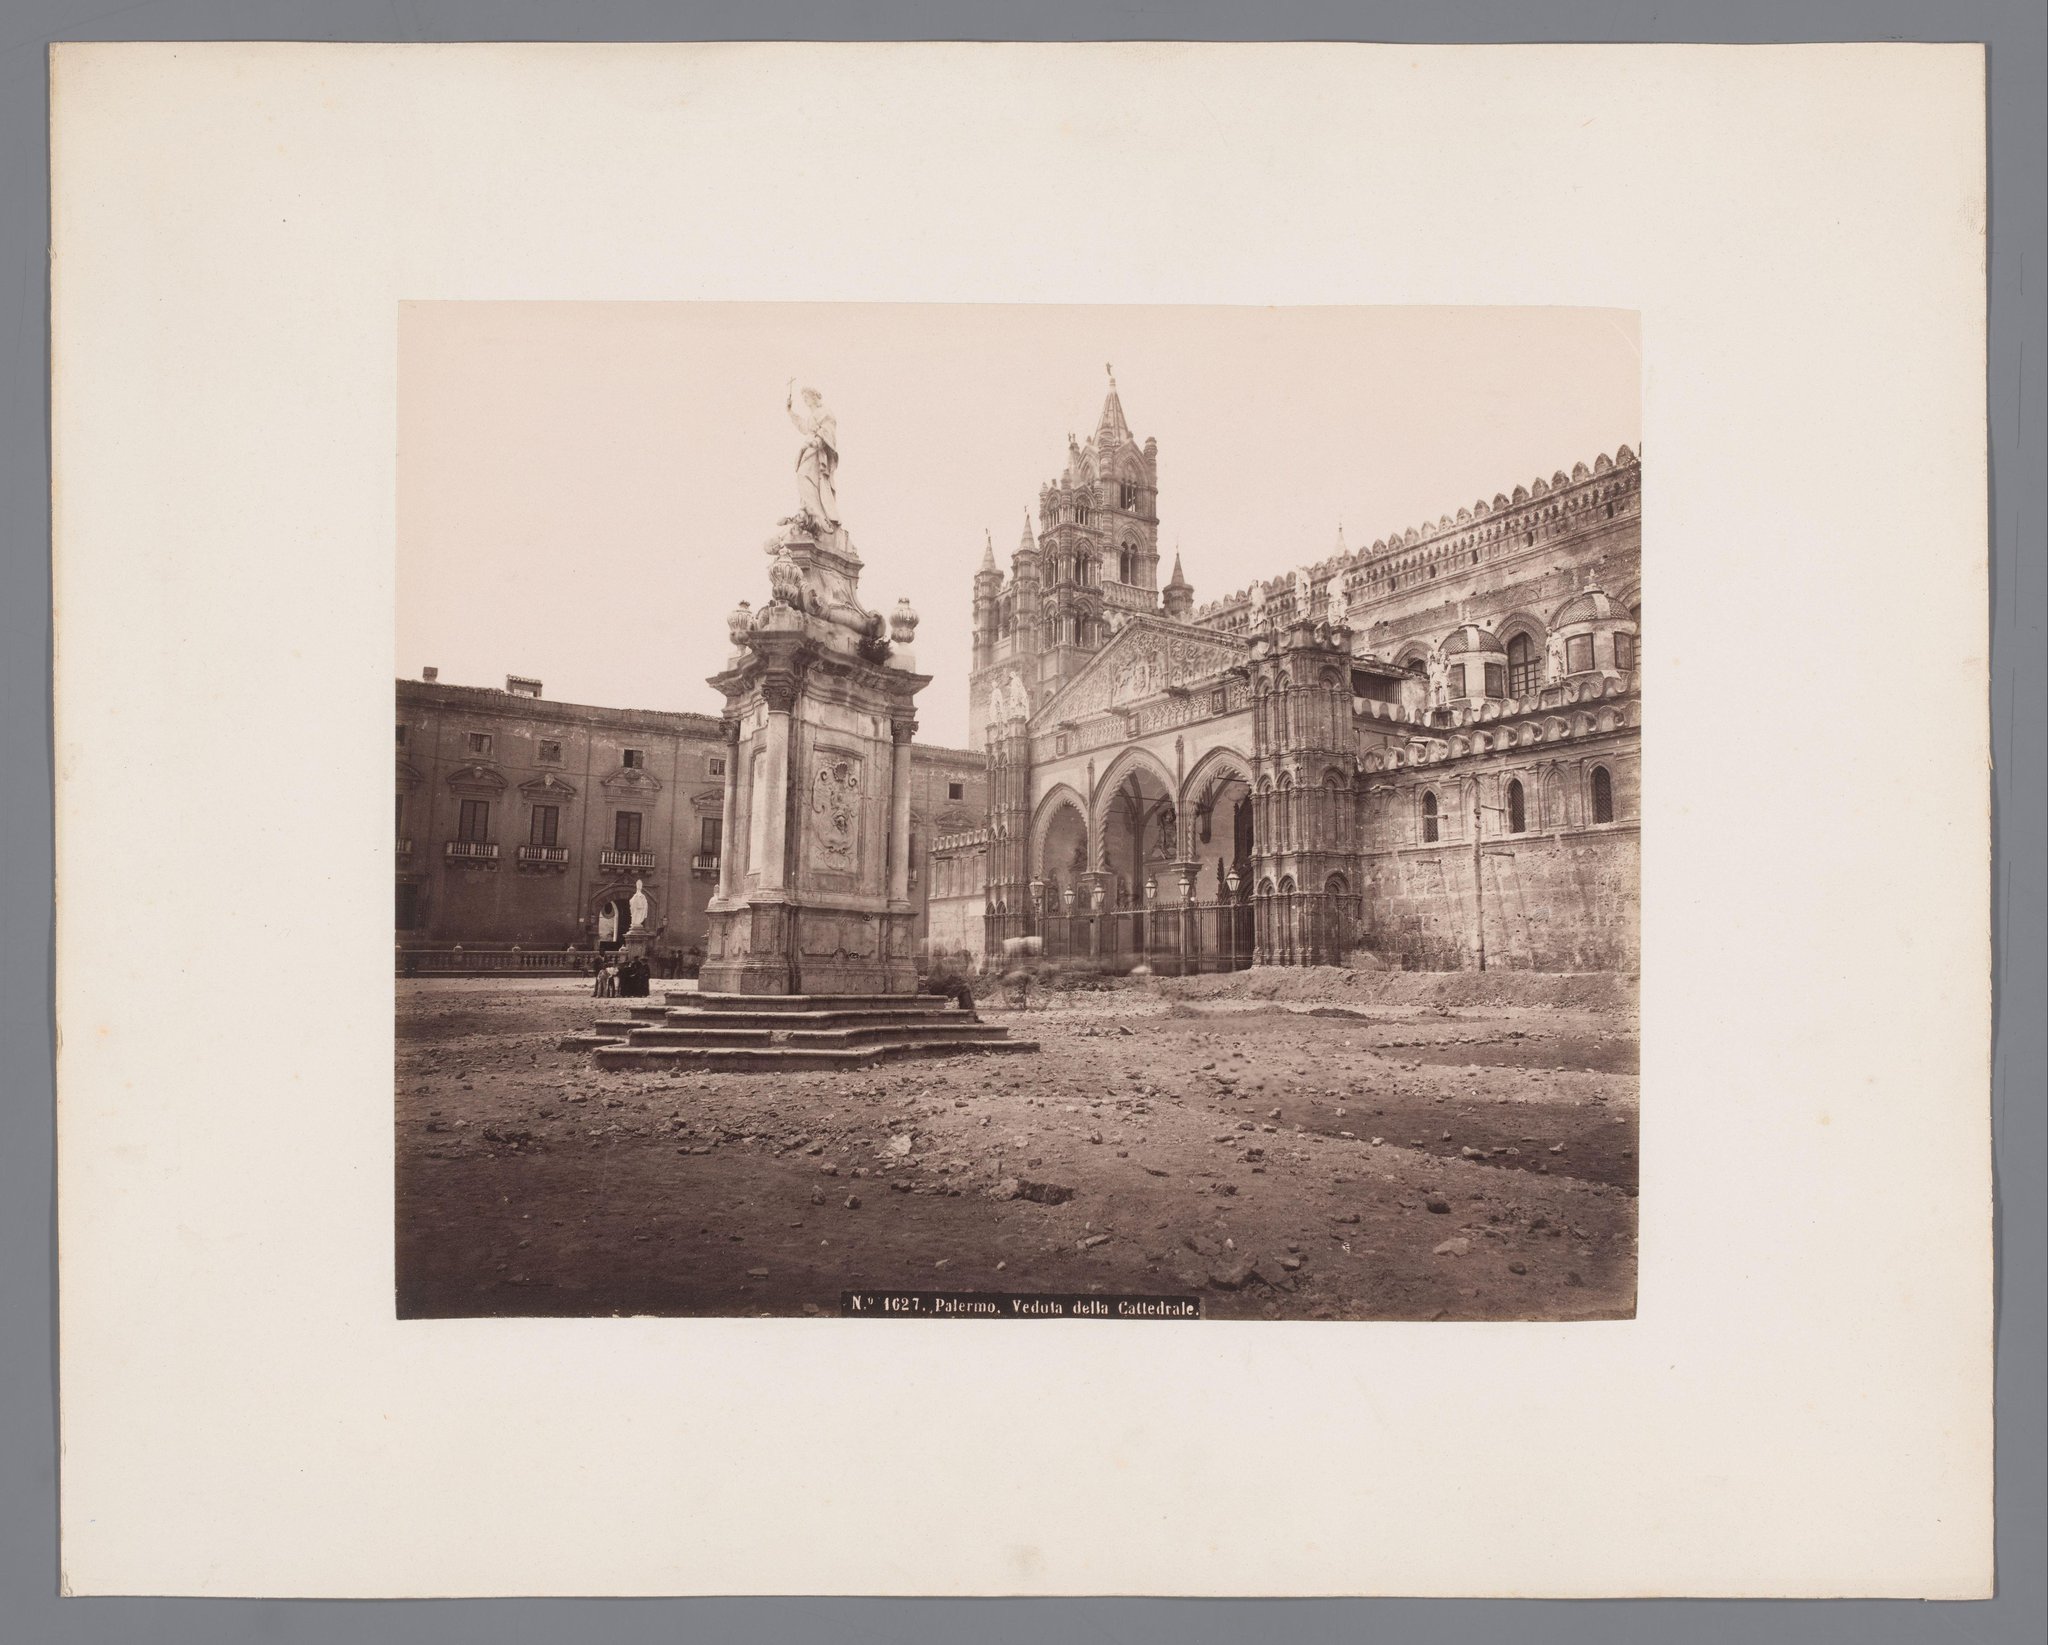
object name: photograph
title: Veduta della Cattedrale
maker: Anonymous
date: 1851-1900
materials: cardboard, paper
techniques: albumen print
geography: palermo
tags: church (exterior), monument, statue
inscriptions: number: ‘No. 1627.’